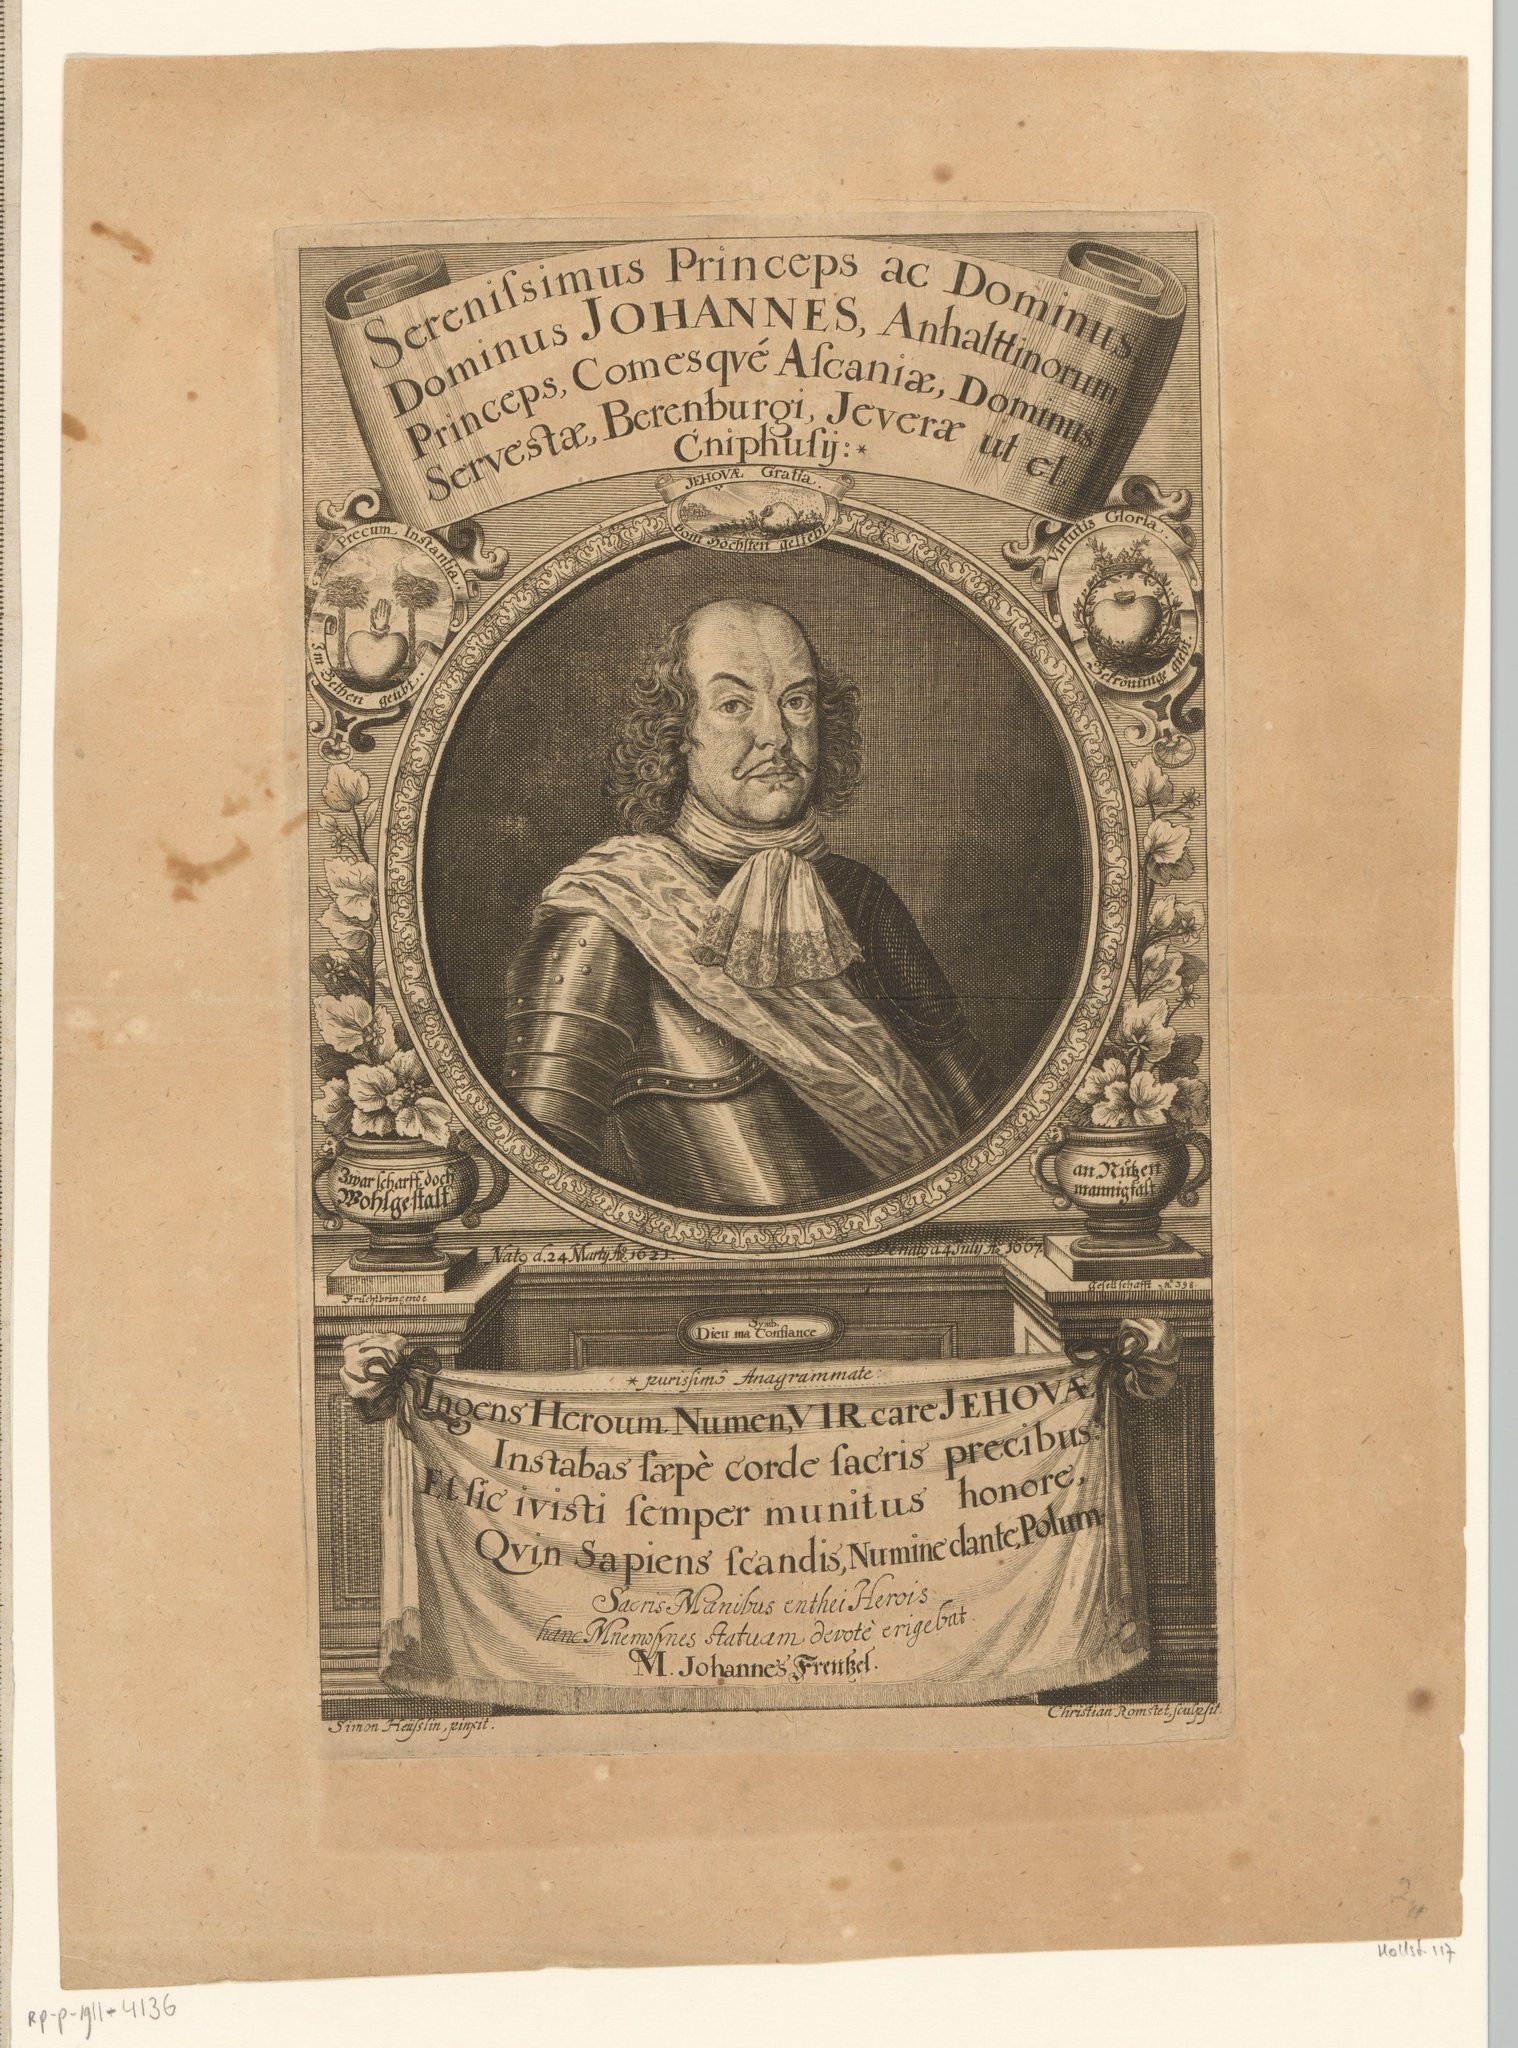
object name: print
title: Portret van Johann VI von Anhalt-Zerbst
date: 1665-1721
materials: paper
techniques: engraving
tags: flowers, armour, historical persons, container of stone: stone vase, abstract ideas and concepts (+ emblematical representation of concept)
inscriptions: collector's mark: Lugt 2228